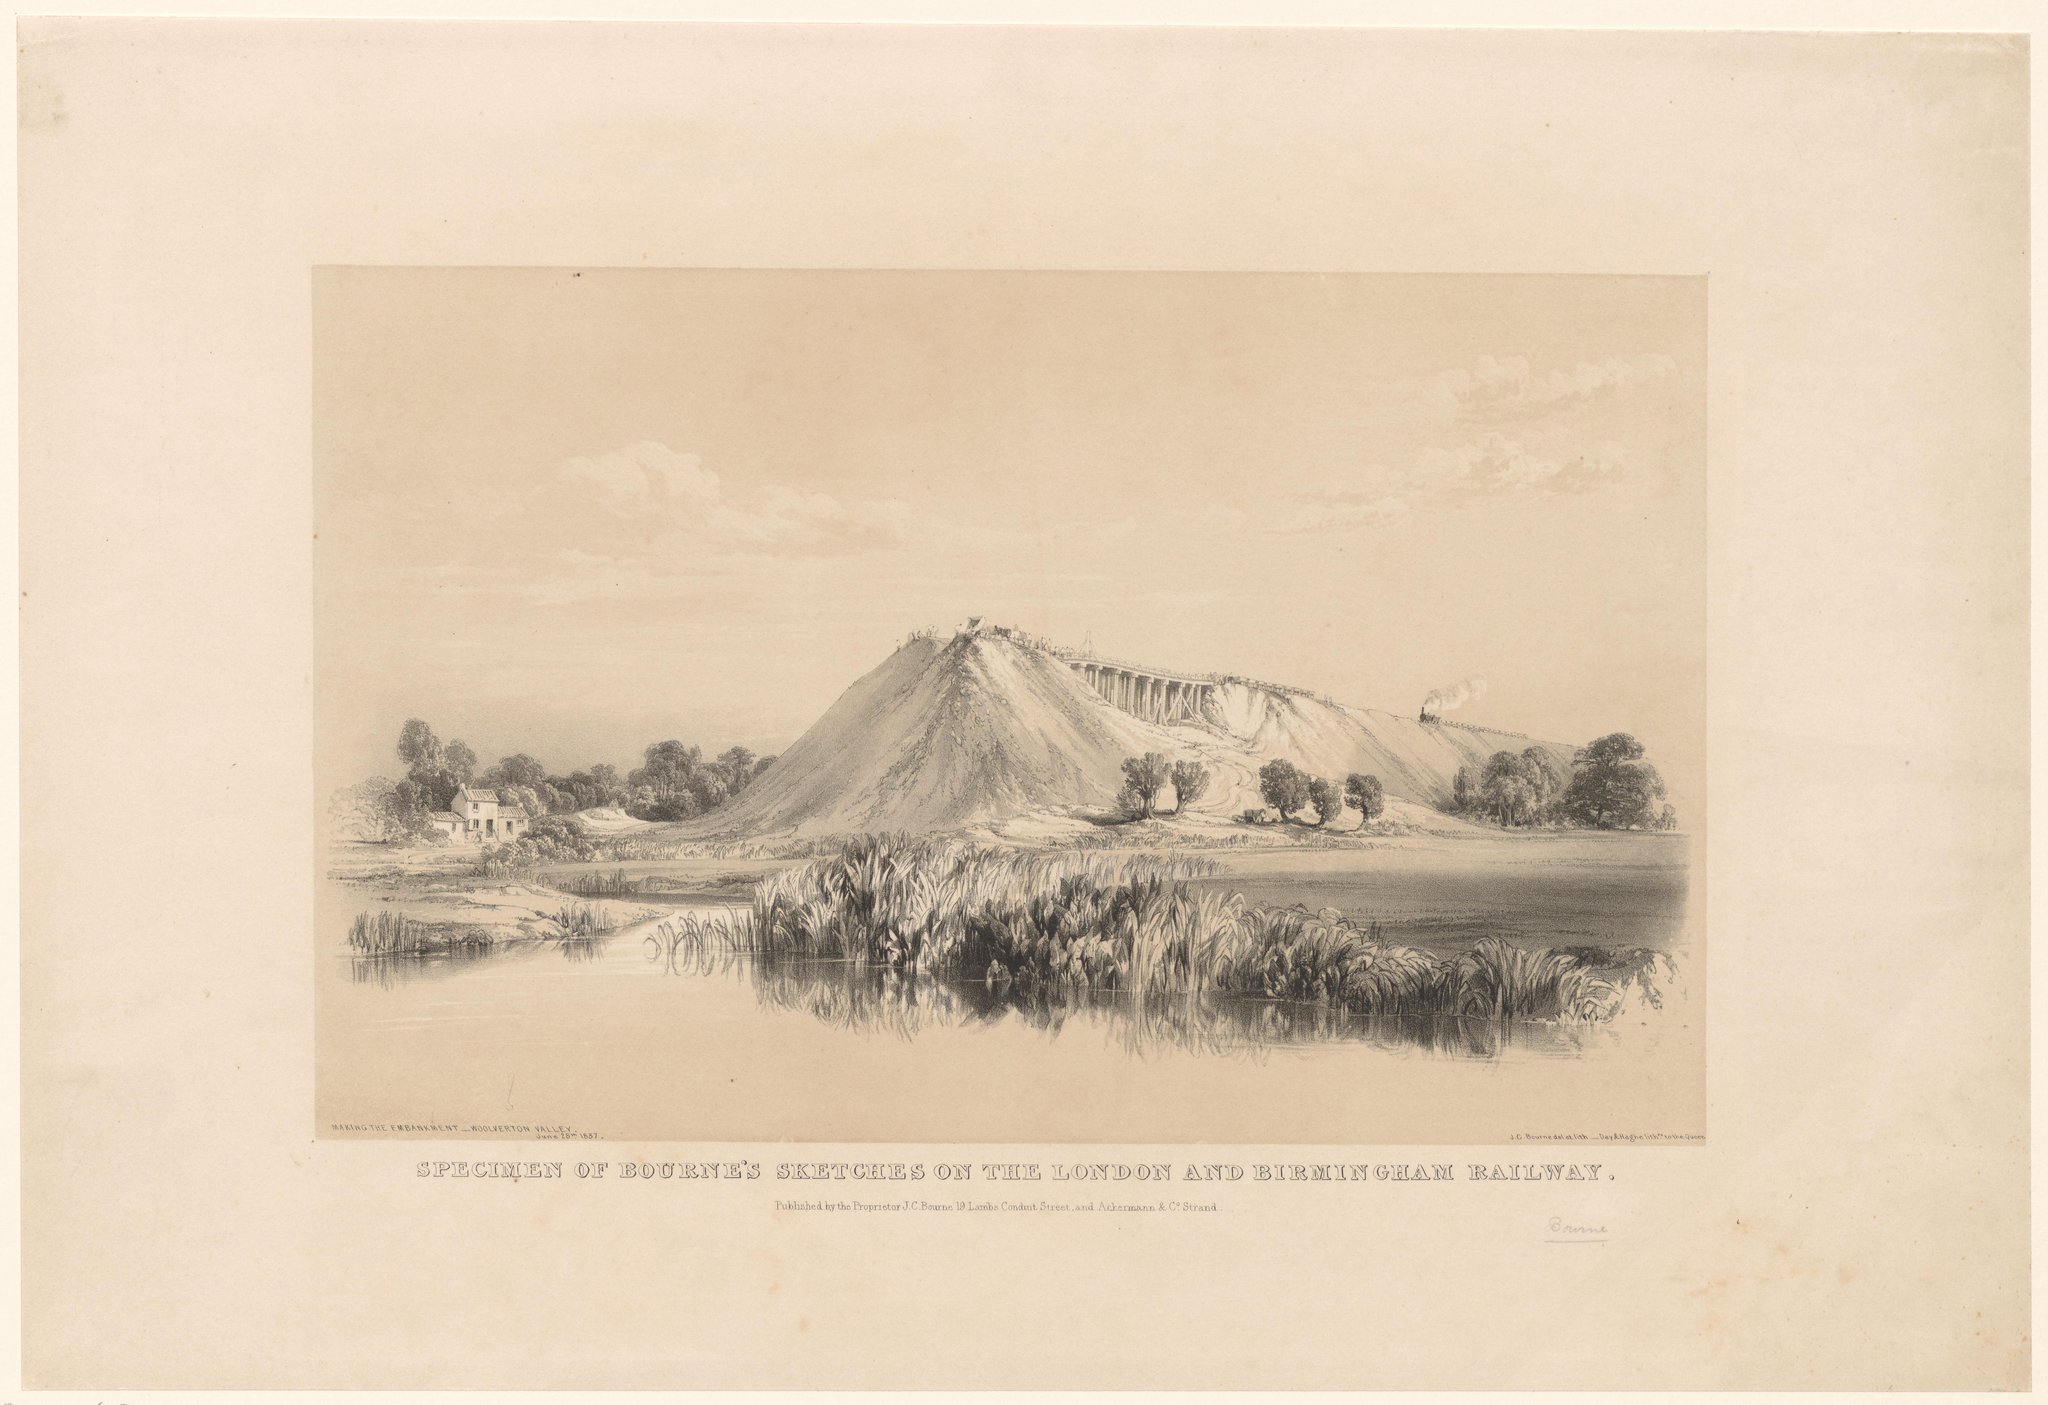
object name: print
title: A Series of Lithographic Drawings on the London and Birmingham Railway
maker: john cooke bourne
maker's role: print maker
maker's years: 1814-1896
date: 1838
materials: paper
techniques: tone lithography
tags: railway, train, landscapes in the temperate zone (+ landscape with figures, staffage)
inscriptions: collector's mark: Lugt 2228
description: Deze prent behoort tot de serie 'A Series of Lithographic Drawings on the London and Birmingham Railway'. De serie bestaat uit ongeveer 37 lithografieën die in vier delen zijn gepubliceerd. De serie toont de aanleg van de treinverbinding tussen Londen en Birmingham in 1837-1838.